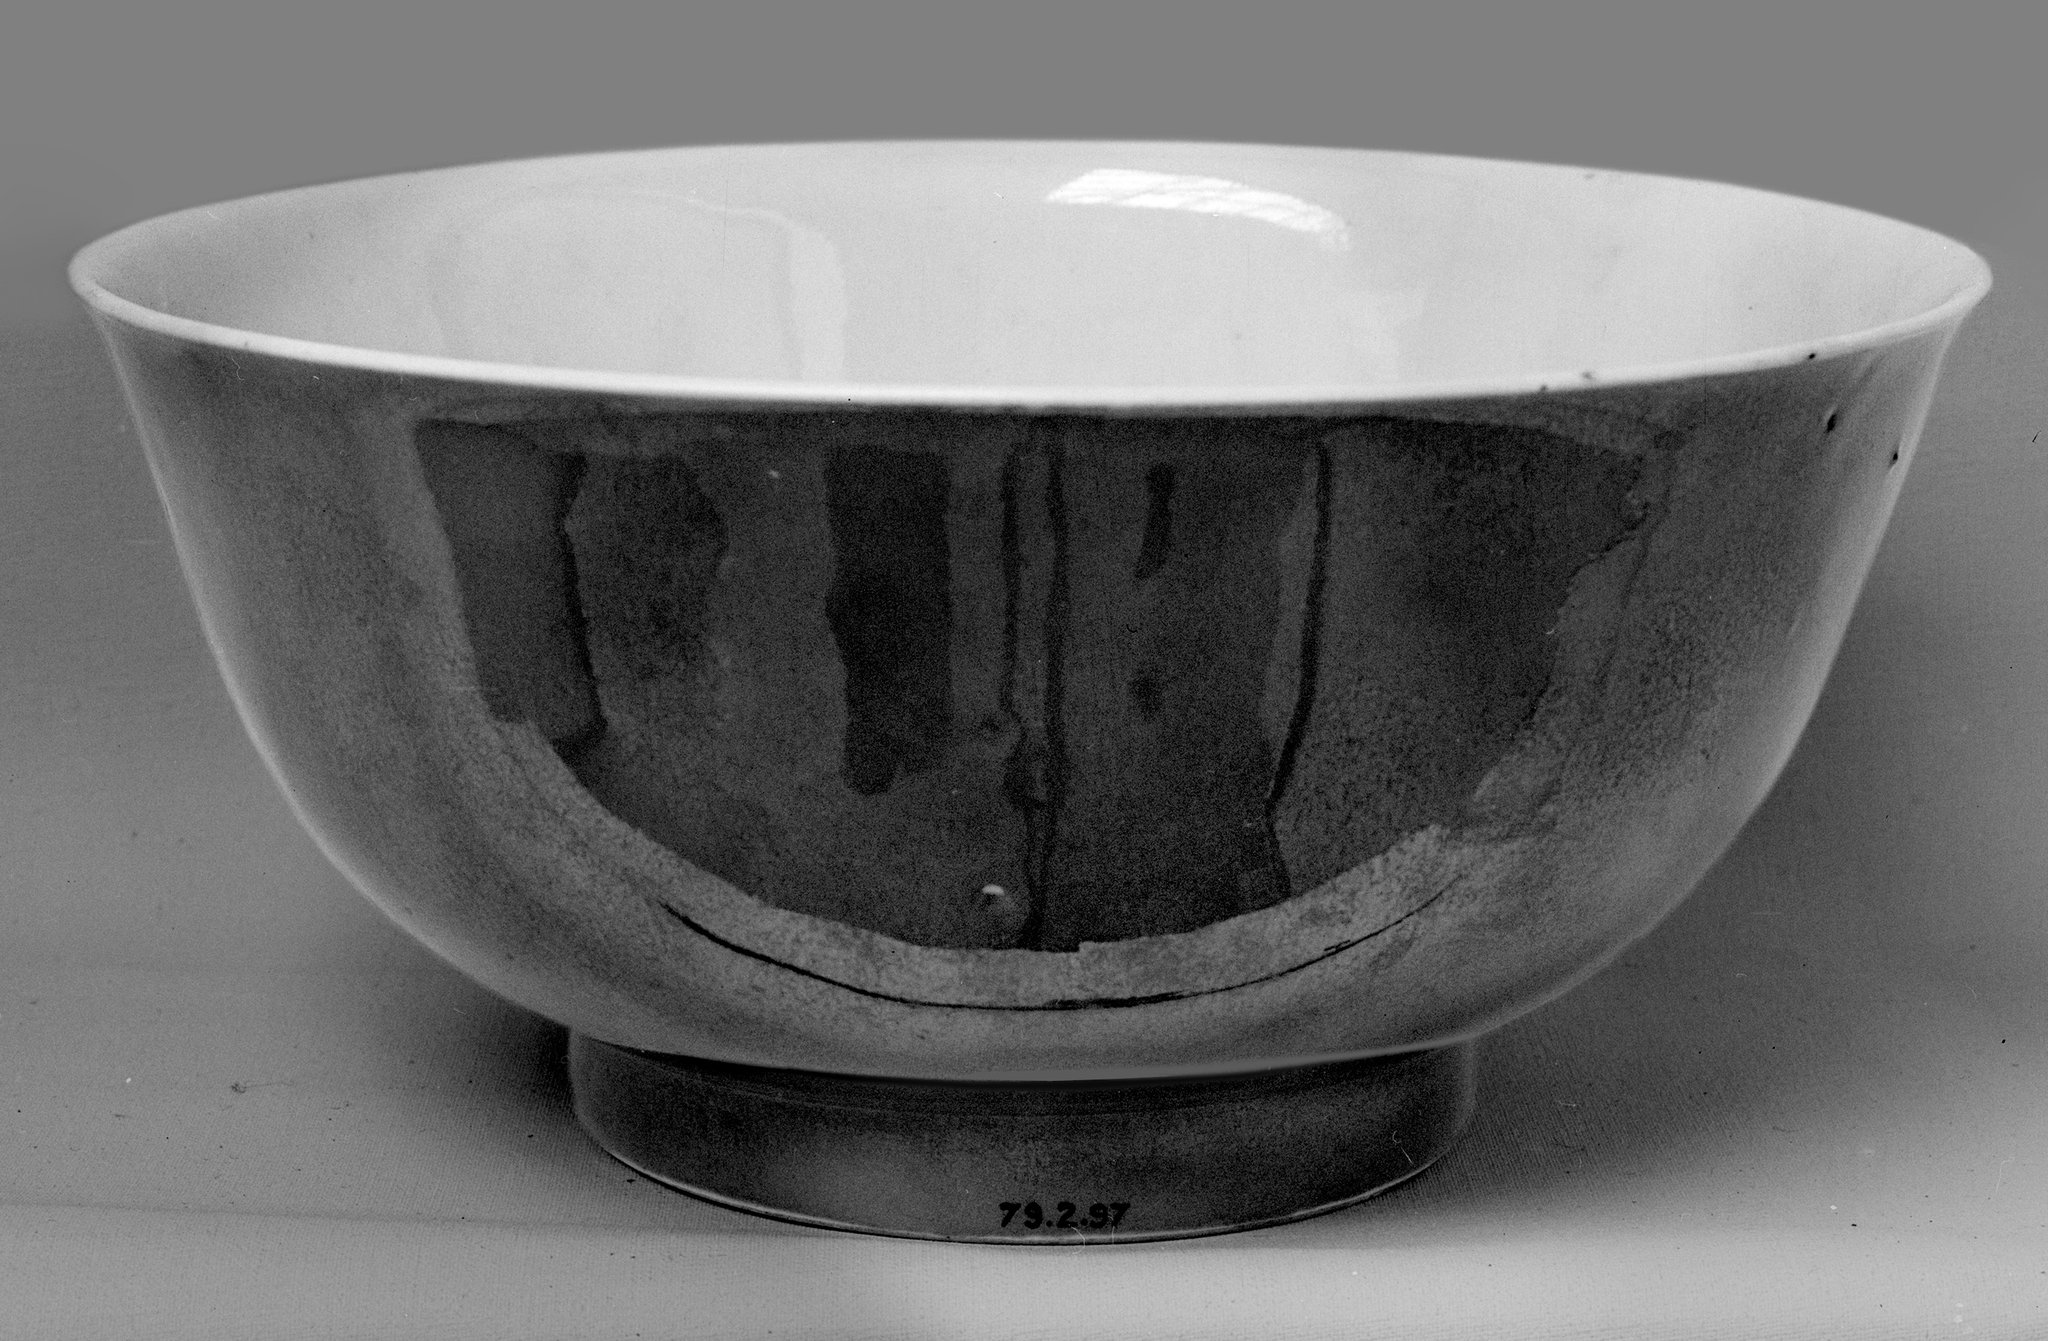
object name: bowl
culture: chinese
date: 1667-1733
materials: glaze, porcelain